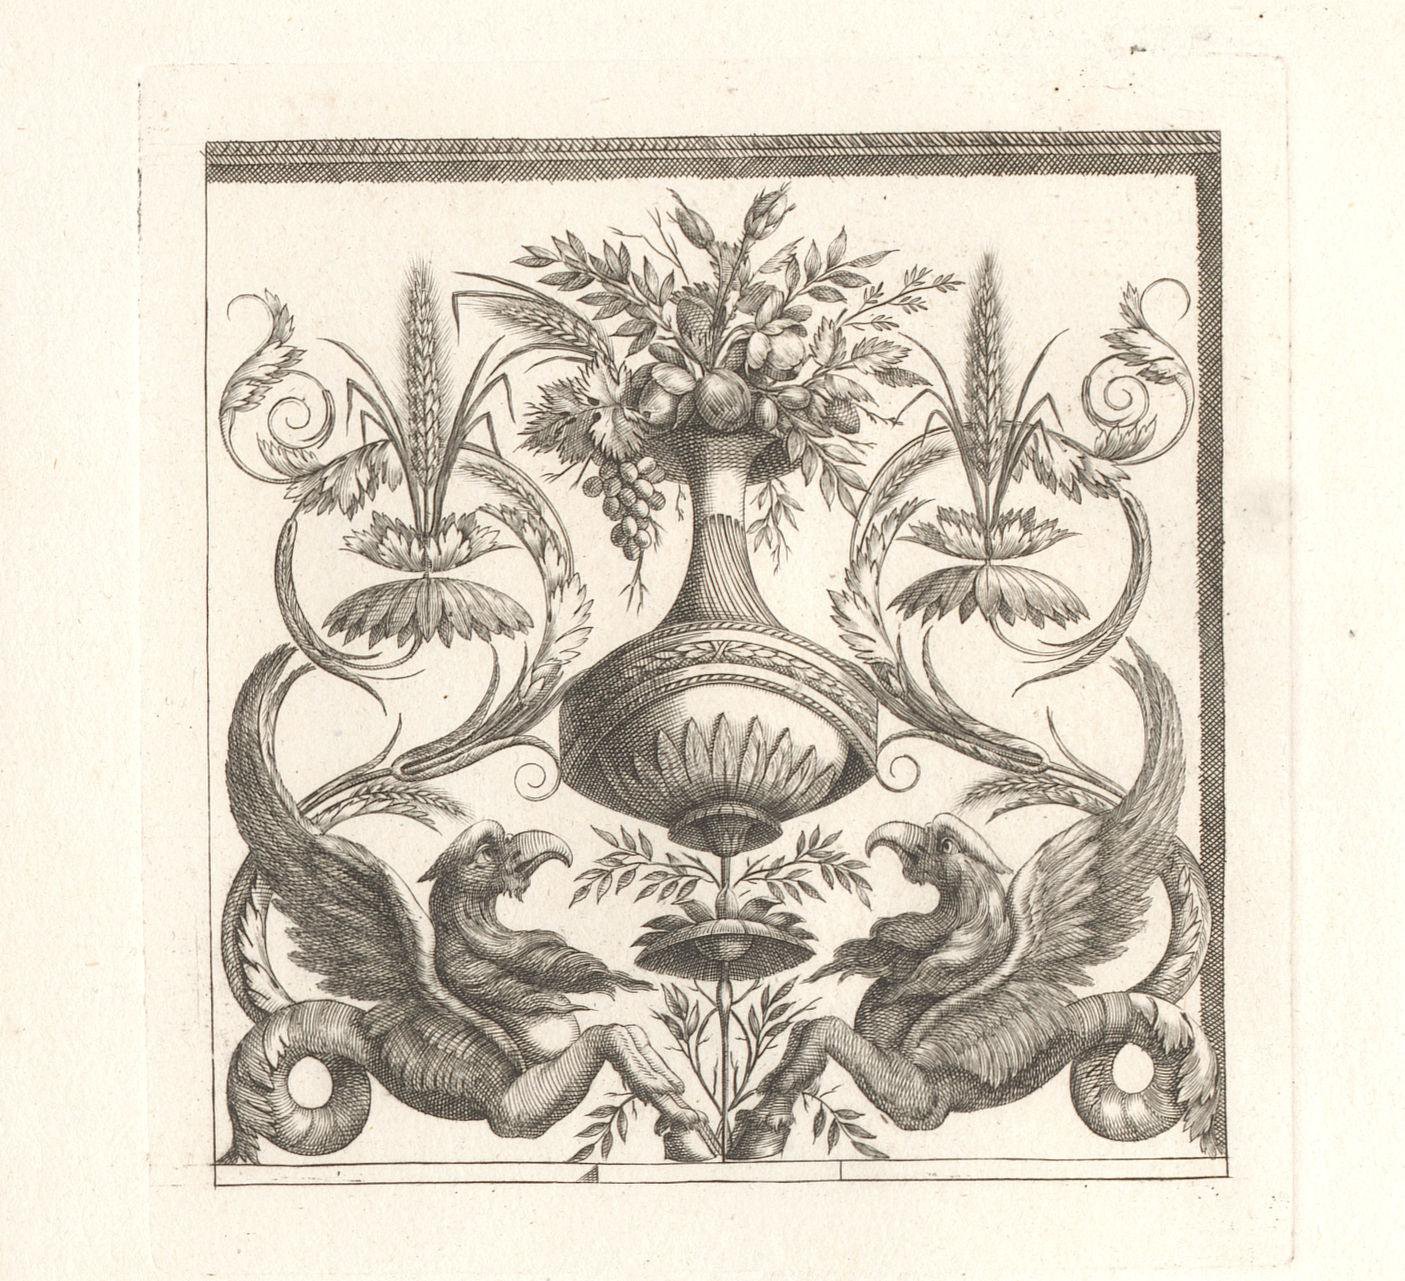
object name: ornament print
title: Ornament met twee griffioenen aan weerszijden van een vaas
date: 1802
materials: paper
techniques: engraving, etching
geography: paris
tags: griffin (lion/eagle); 'griffo' (ripa), ornament ~ arabesque, ornament derived from plant forms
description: Doordat dit album bestaat uit meerdere, deels eerder uitgegeven prentreeksen, is de datering niet consequent. Het geheel is op de titelpagina gedateerd op 1802. Deze reeks is niet afzonderlijk gedateerd. De serietitel voor het gehele werk is "Recueil d'arabesques, contenant les loges du Vatican". De andere serietitel is de titel van de specifieke reeks binnen het geheel.